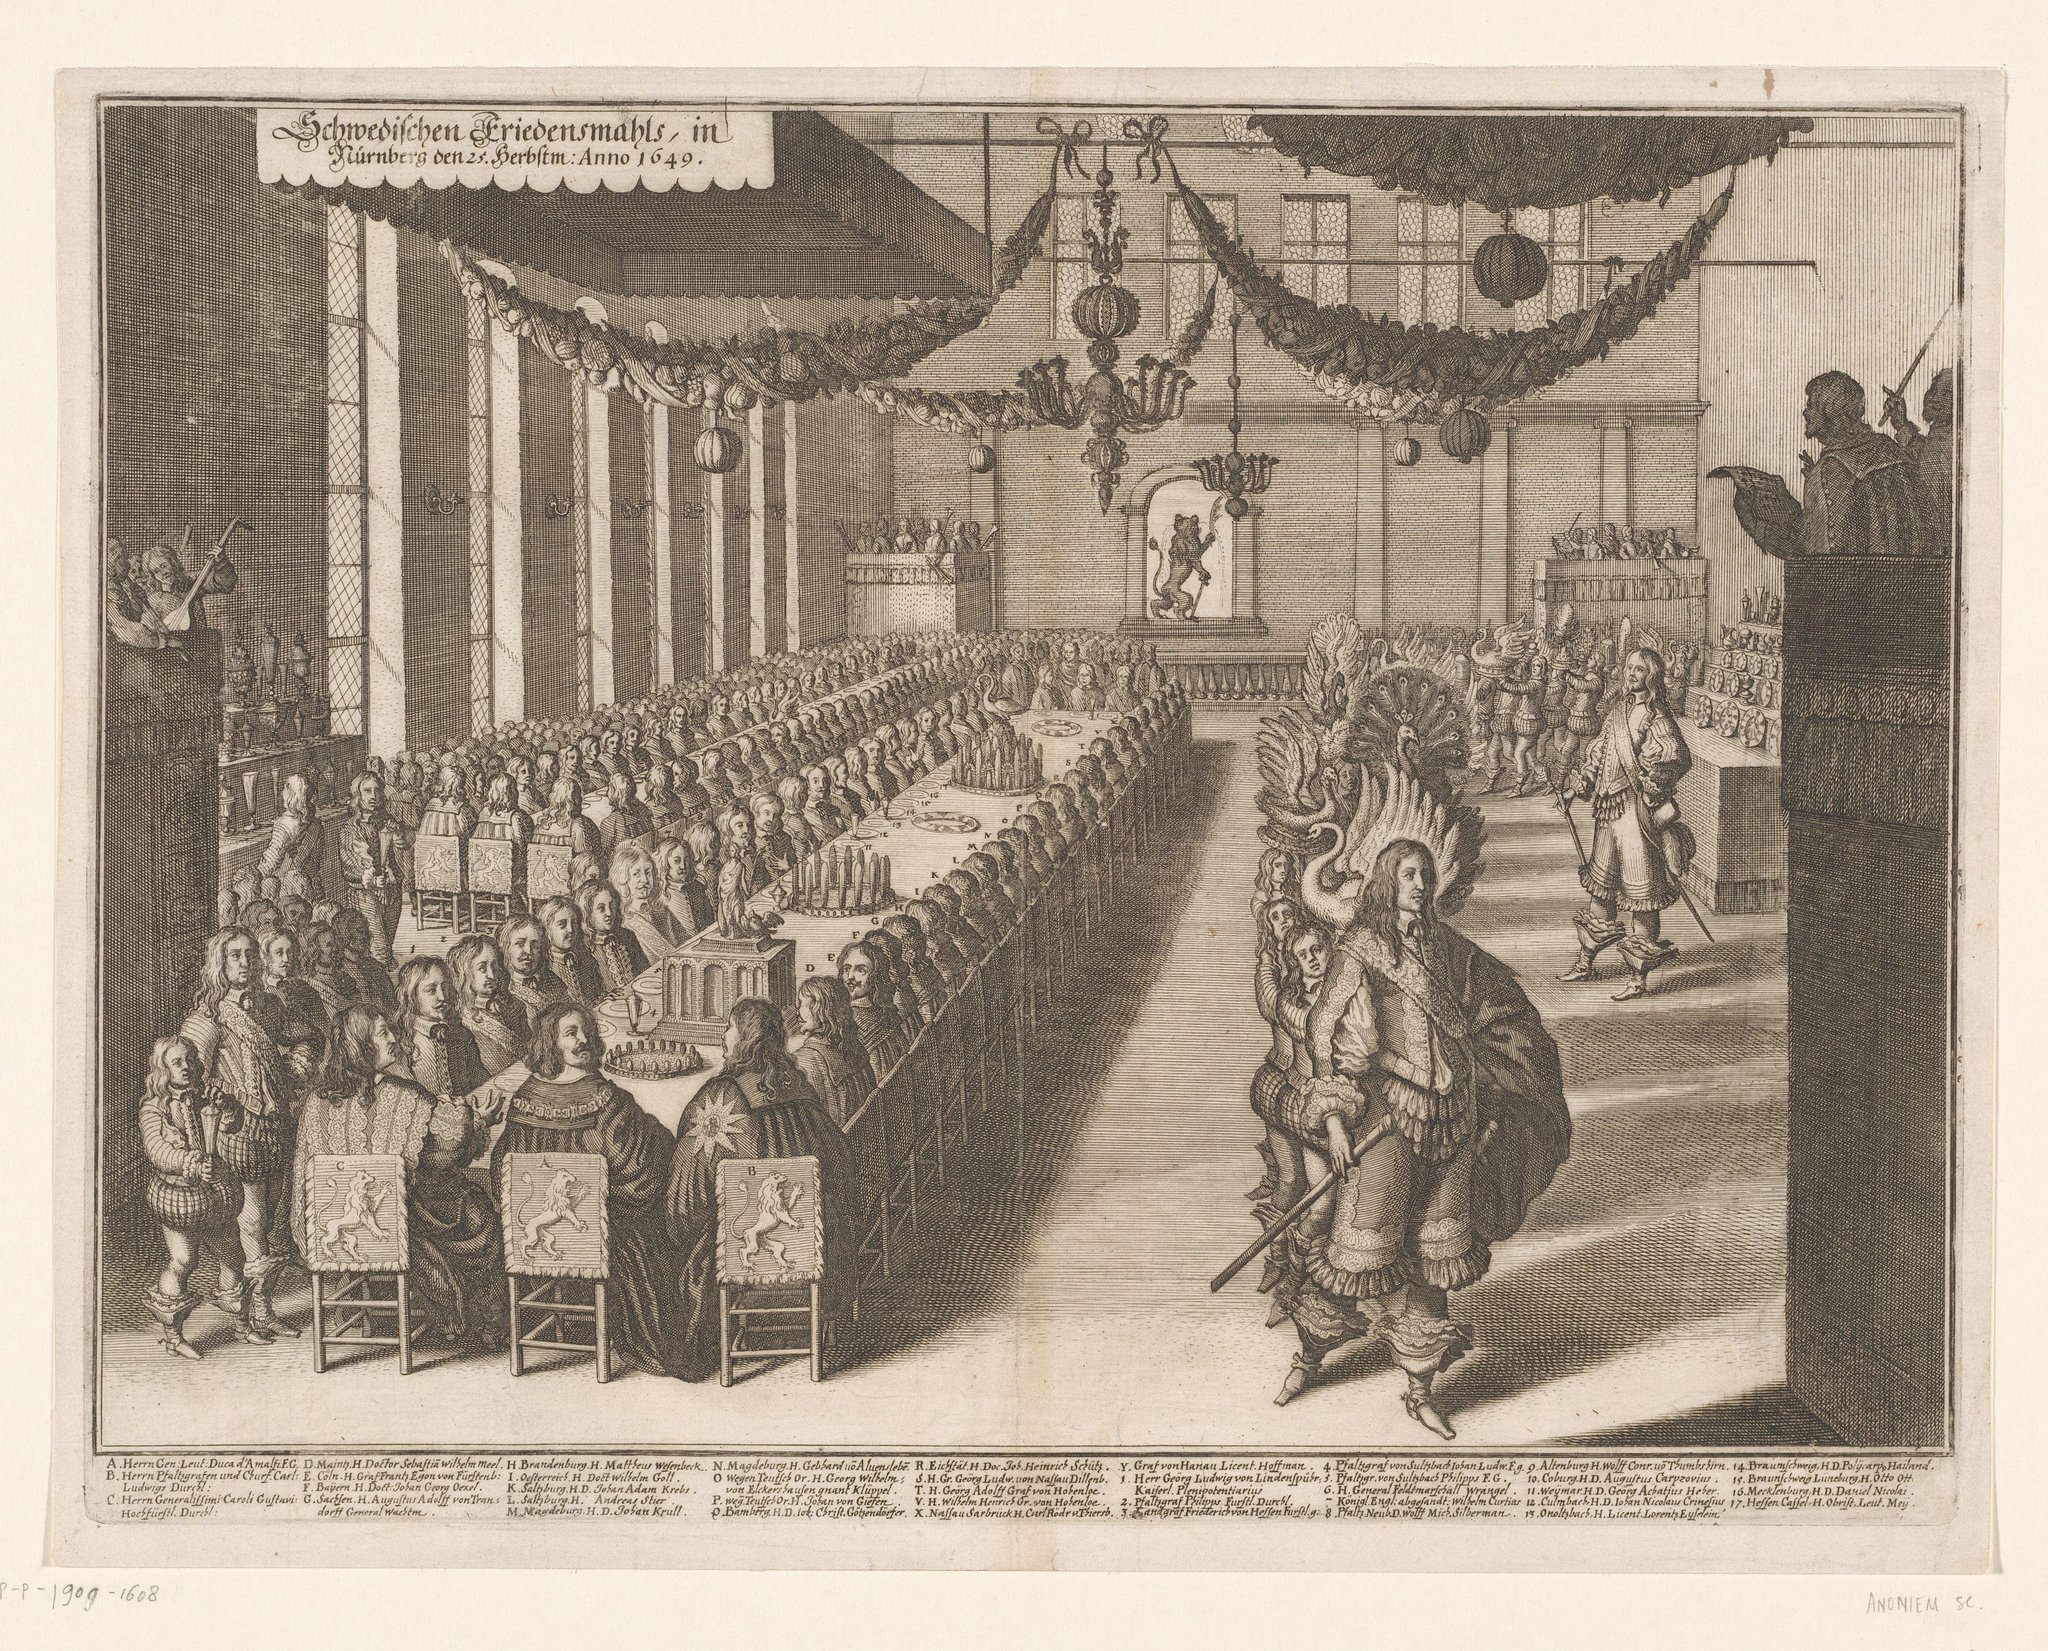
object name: print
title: Schwedischen Friedensmahls, in Nürnberg den 25. herbstm: Anno 1649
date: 1650-1663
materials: paper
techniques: engraving, etching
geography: germany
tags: celebration meal, feast, banquet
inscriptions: collector's mark: Lugt 2228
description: Feestmaal aangeboden door de Zweedse opperbevelhebber en latere koning Karl Gustav, in Neurenberg ter gelegenheid van de Vrede van Westfalen, 25 september 1649. De gasten gezeten aan lange tafels in de zaal van het Raadhuis. Onderaan de namen van de zitters aan de eerste tafel. In een lange stoet worden de gerechten binnengedragen. Verschillende vogelpasteien.